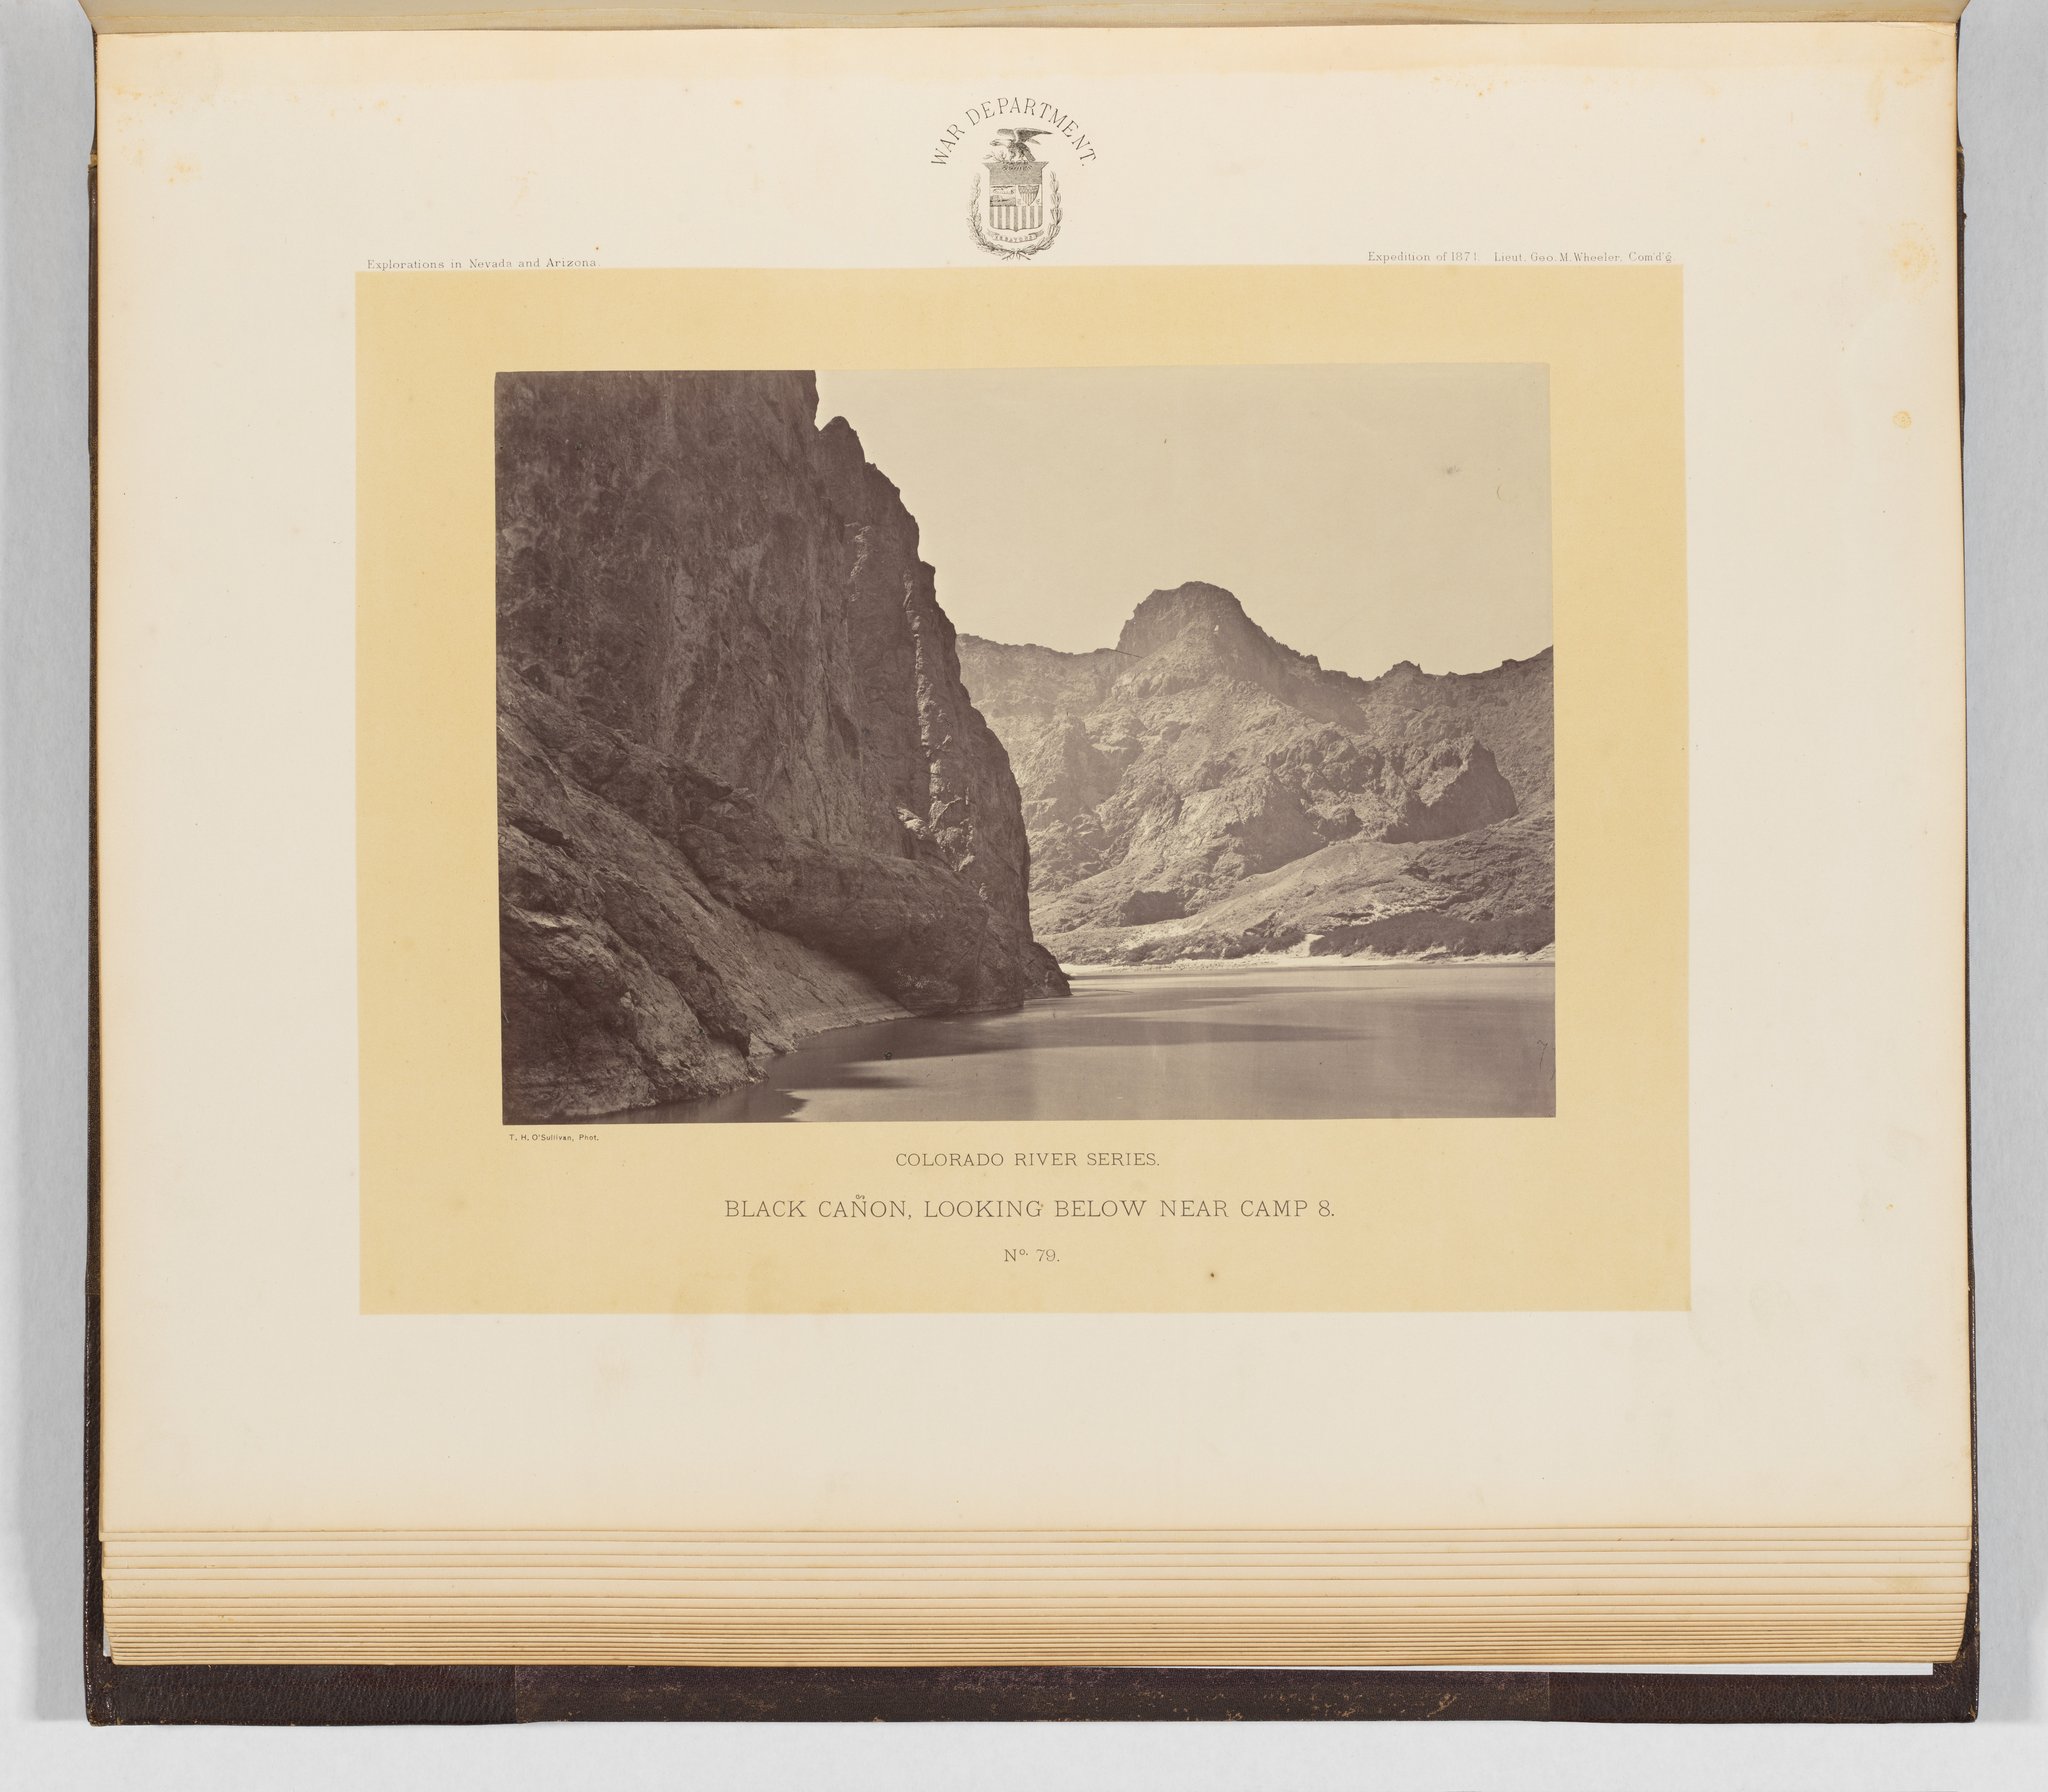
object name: photograph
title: Black Cañon, Looking Below Near Camp 8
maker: timothy h. o'sullivan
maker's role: artist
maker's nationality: american, born ireland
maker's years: 1840-1882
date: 1871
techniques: albumen silver print, glass negative